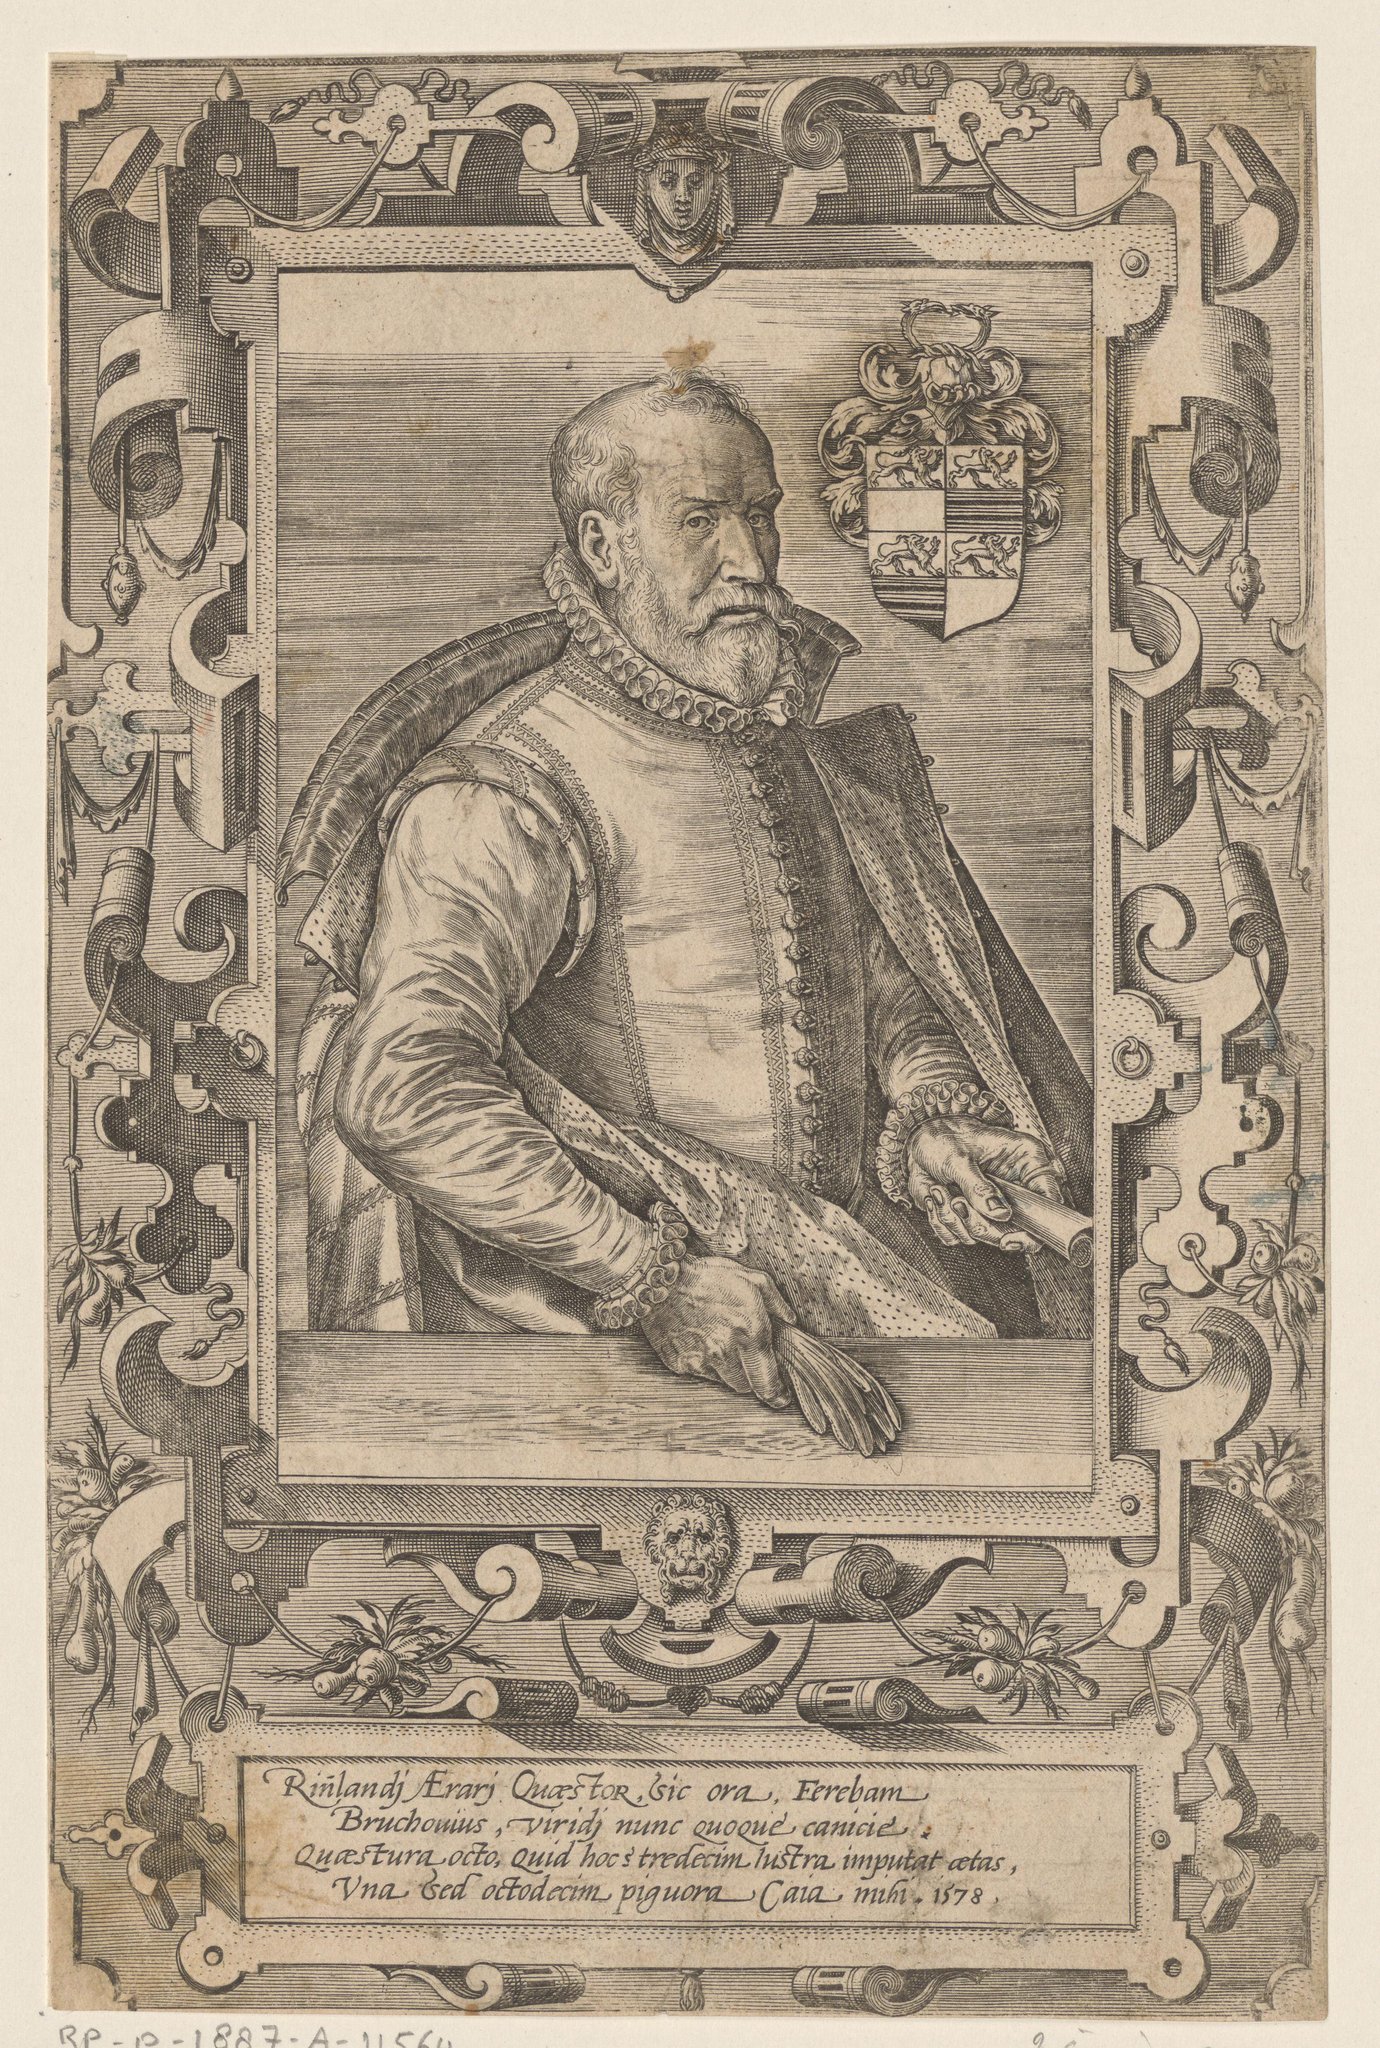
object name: print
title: Portret van Jan van Brouckhoven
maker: johannes wierix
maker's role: draughtsman, print maker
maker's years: 1549-1618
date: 1578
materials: paper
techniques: engraving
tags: mayor, burgomaster, historical persons, armorial bearing, heraldry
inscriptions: collector's mark: Lugt 2228